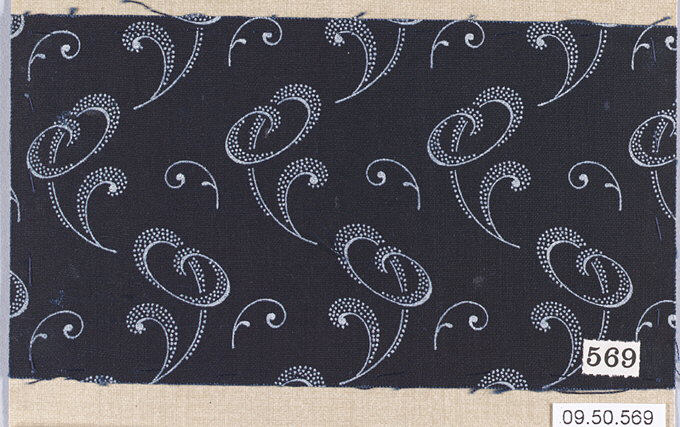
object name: piece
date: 1801-1900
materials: cotton